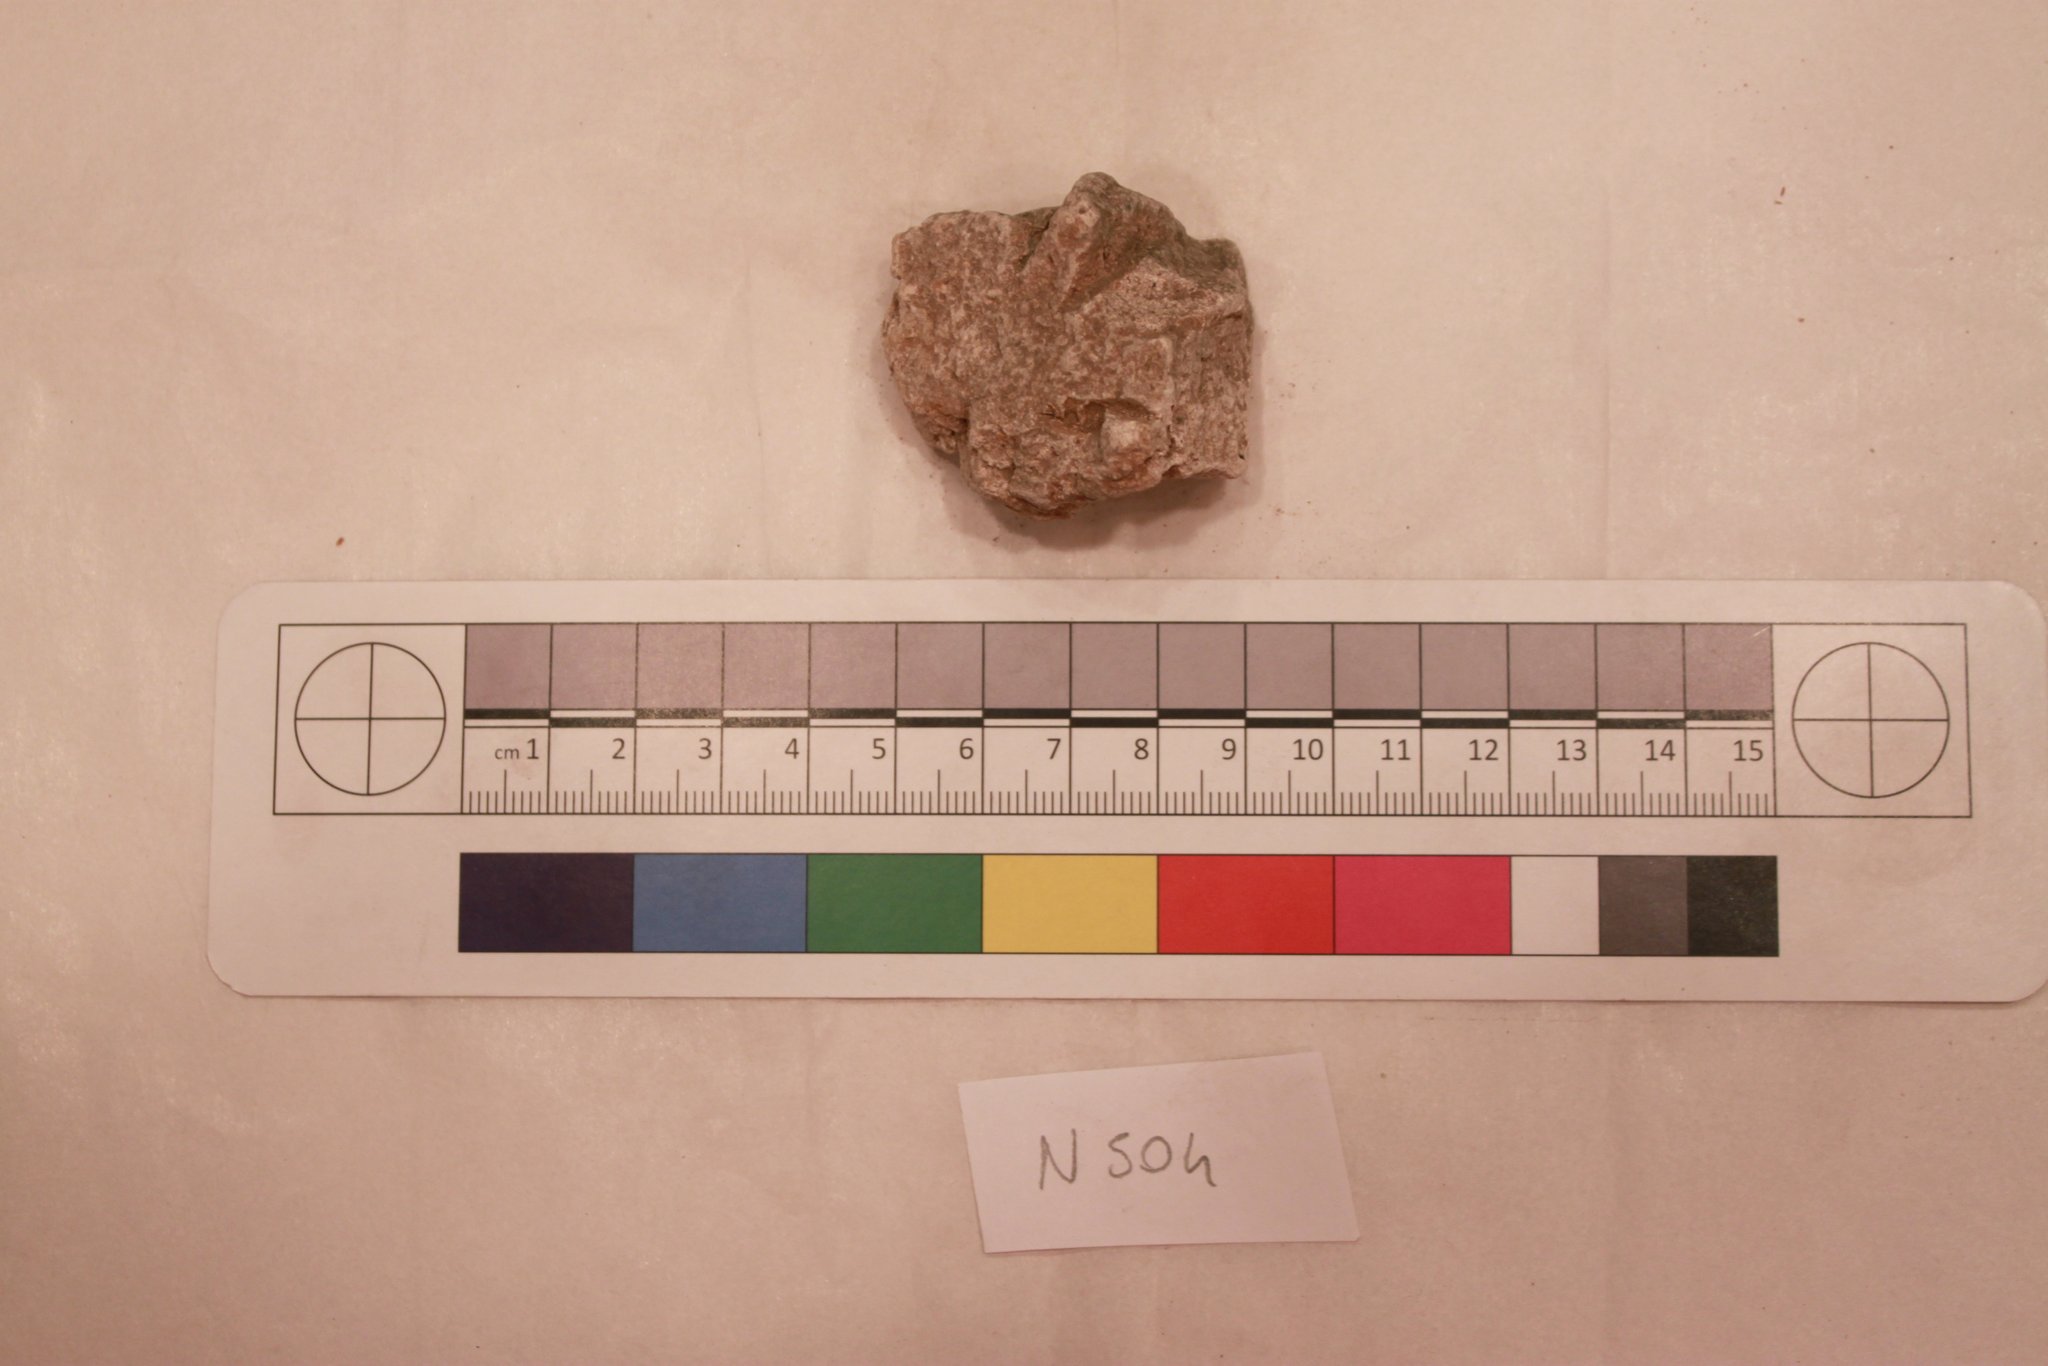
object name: fragment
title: Stucco Fragment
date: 701-1200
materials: plaster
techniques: carving, painting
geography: iran